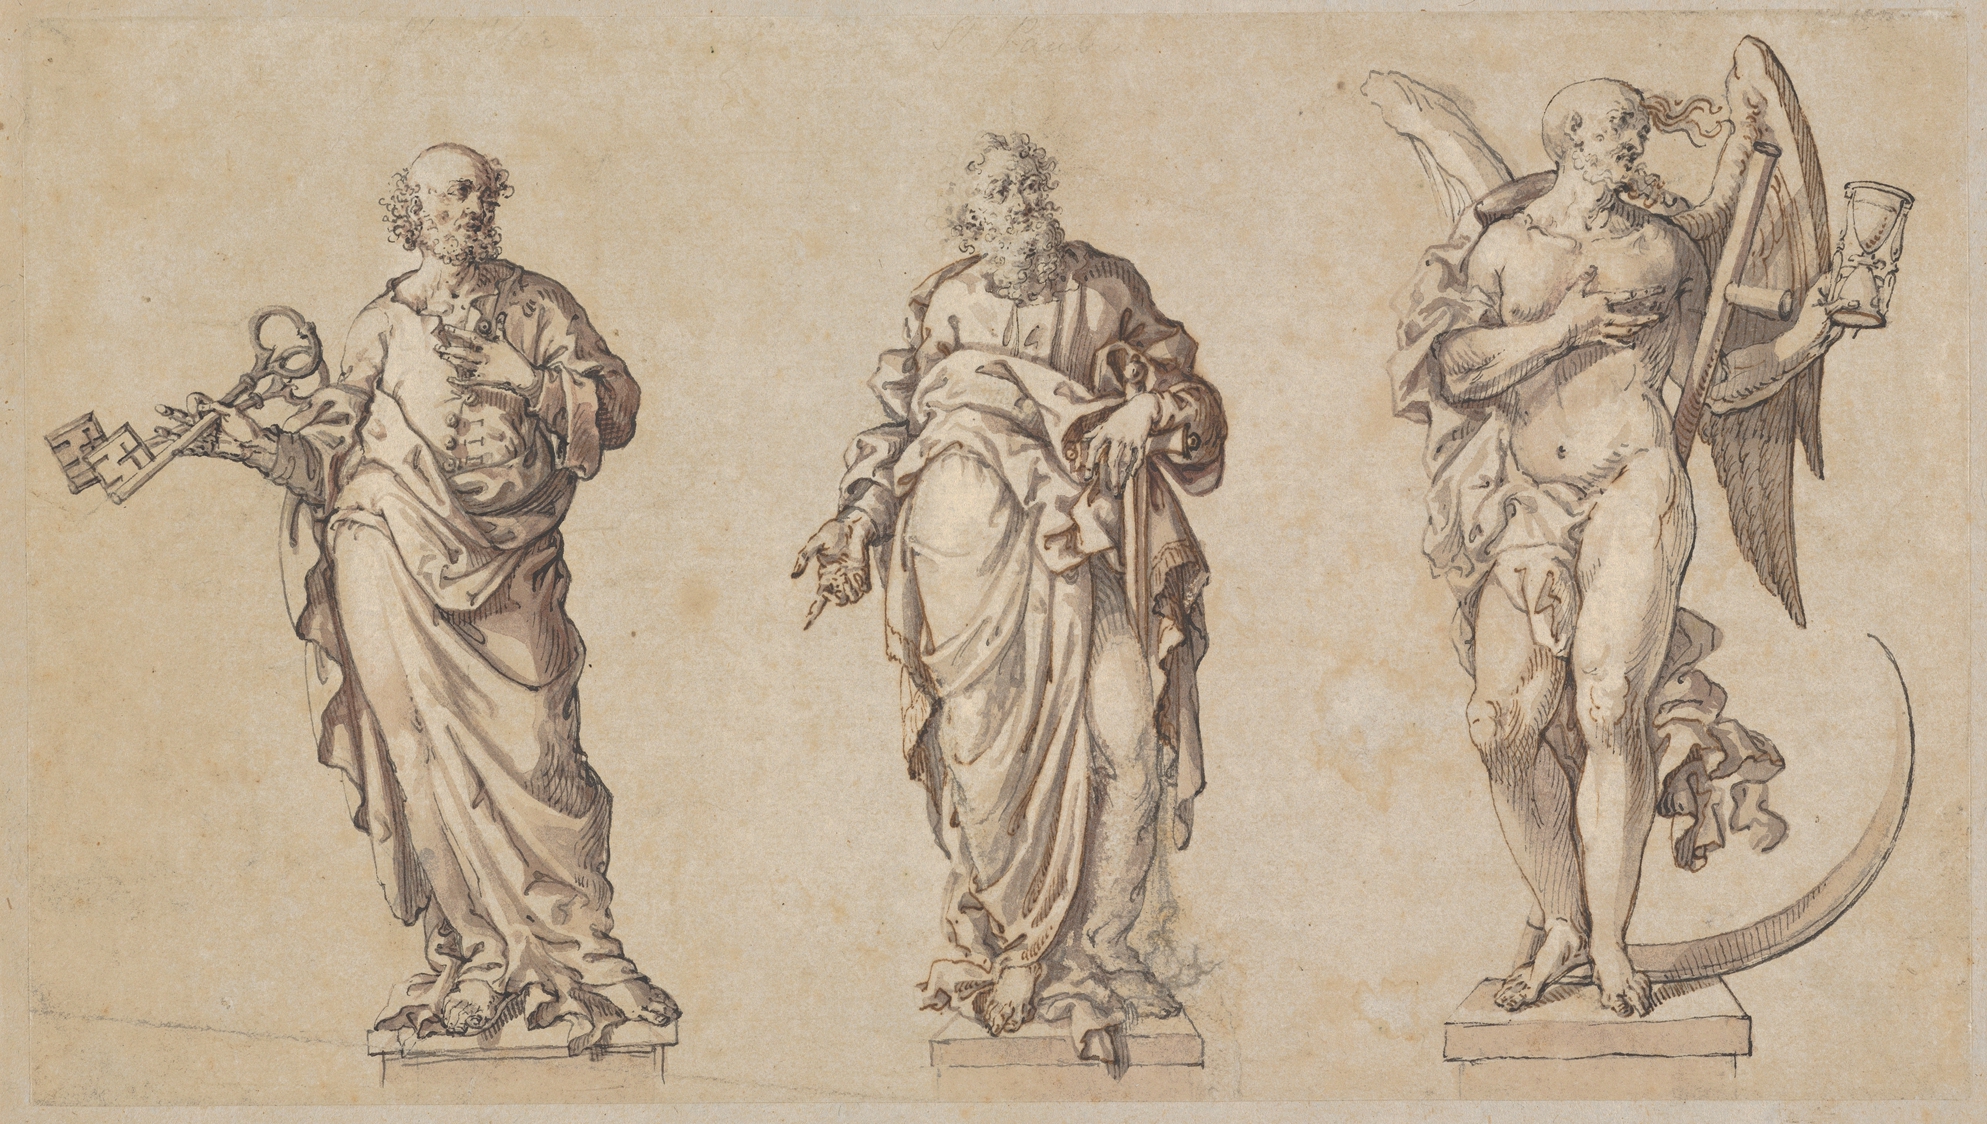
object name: drawing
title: Sculpture Designs for Saint Peter, Saint Paul, and the Angel of Death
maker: anonymous, german, augsburg or munich, early 17th century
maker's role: artist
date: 1601-1633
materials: ink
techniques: brush, pen, wash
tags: sculpture,angels,saint paul,saint peter